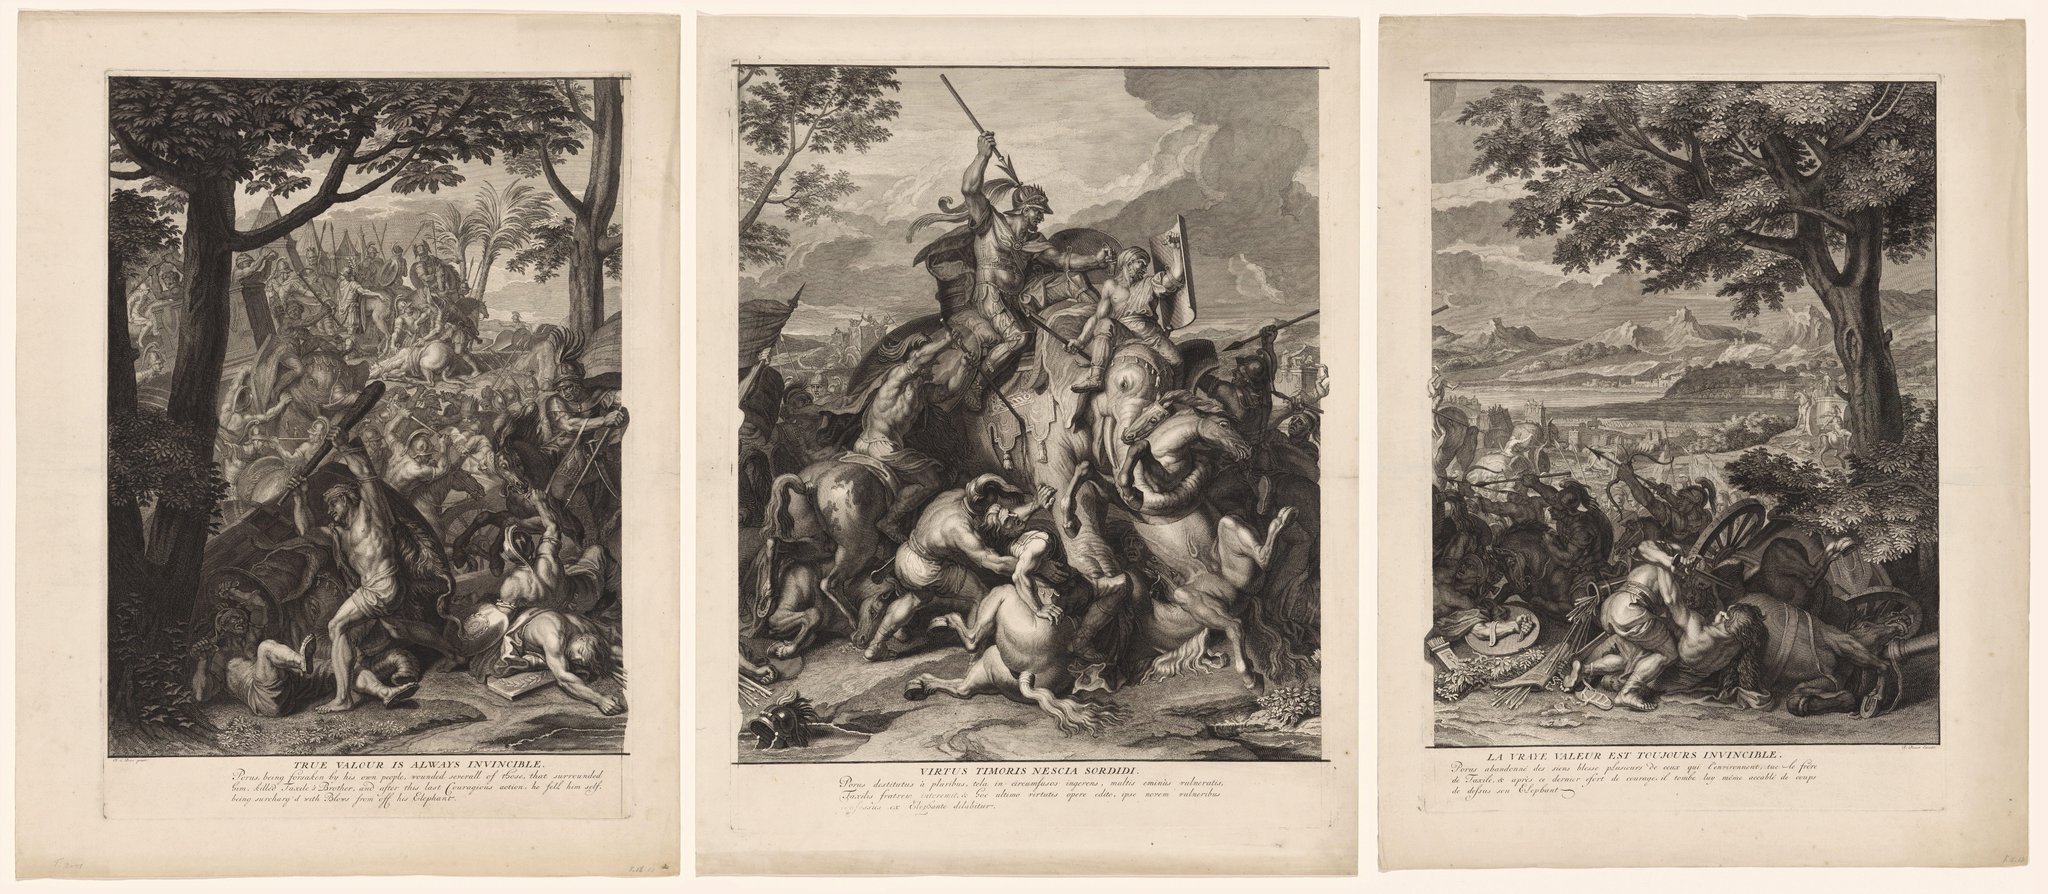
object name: print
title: True valour is always invincible / Virtus timoris nescia sordidi / La vraye valeur est toujours invincible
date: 1717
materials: paper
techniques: engraving, etching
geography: paris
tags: the army of porus and its elephants are conquered by alexander, battle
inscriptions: collector's mark: Lugt 1838, collector's mark: Lugt 240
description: Dit object is omwille van een betere presentatie virtueel samengevoegd, maar bestaat fysiek uit losse onderdelen.